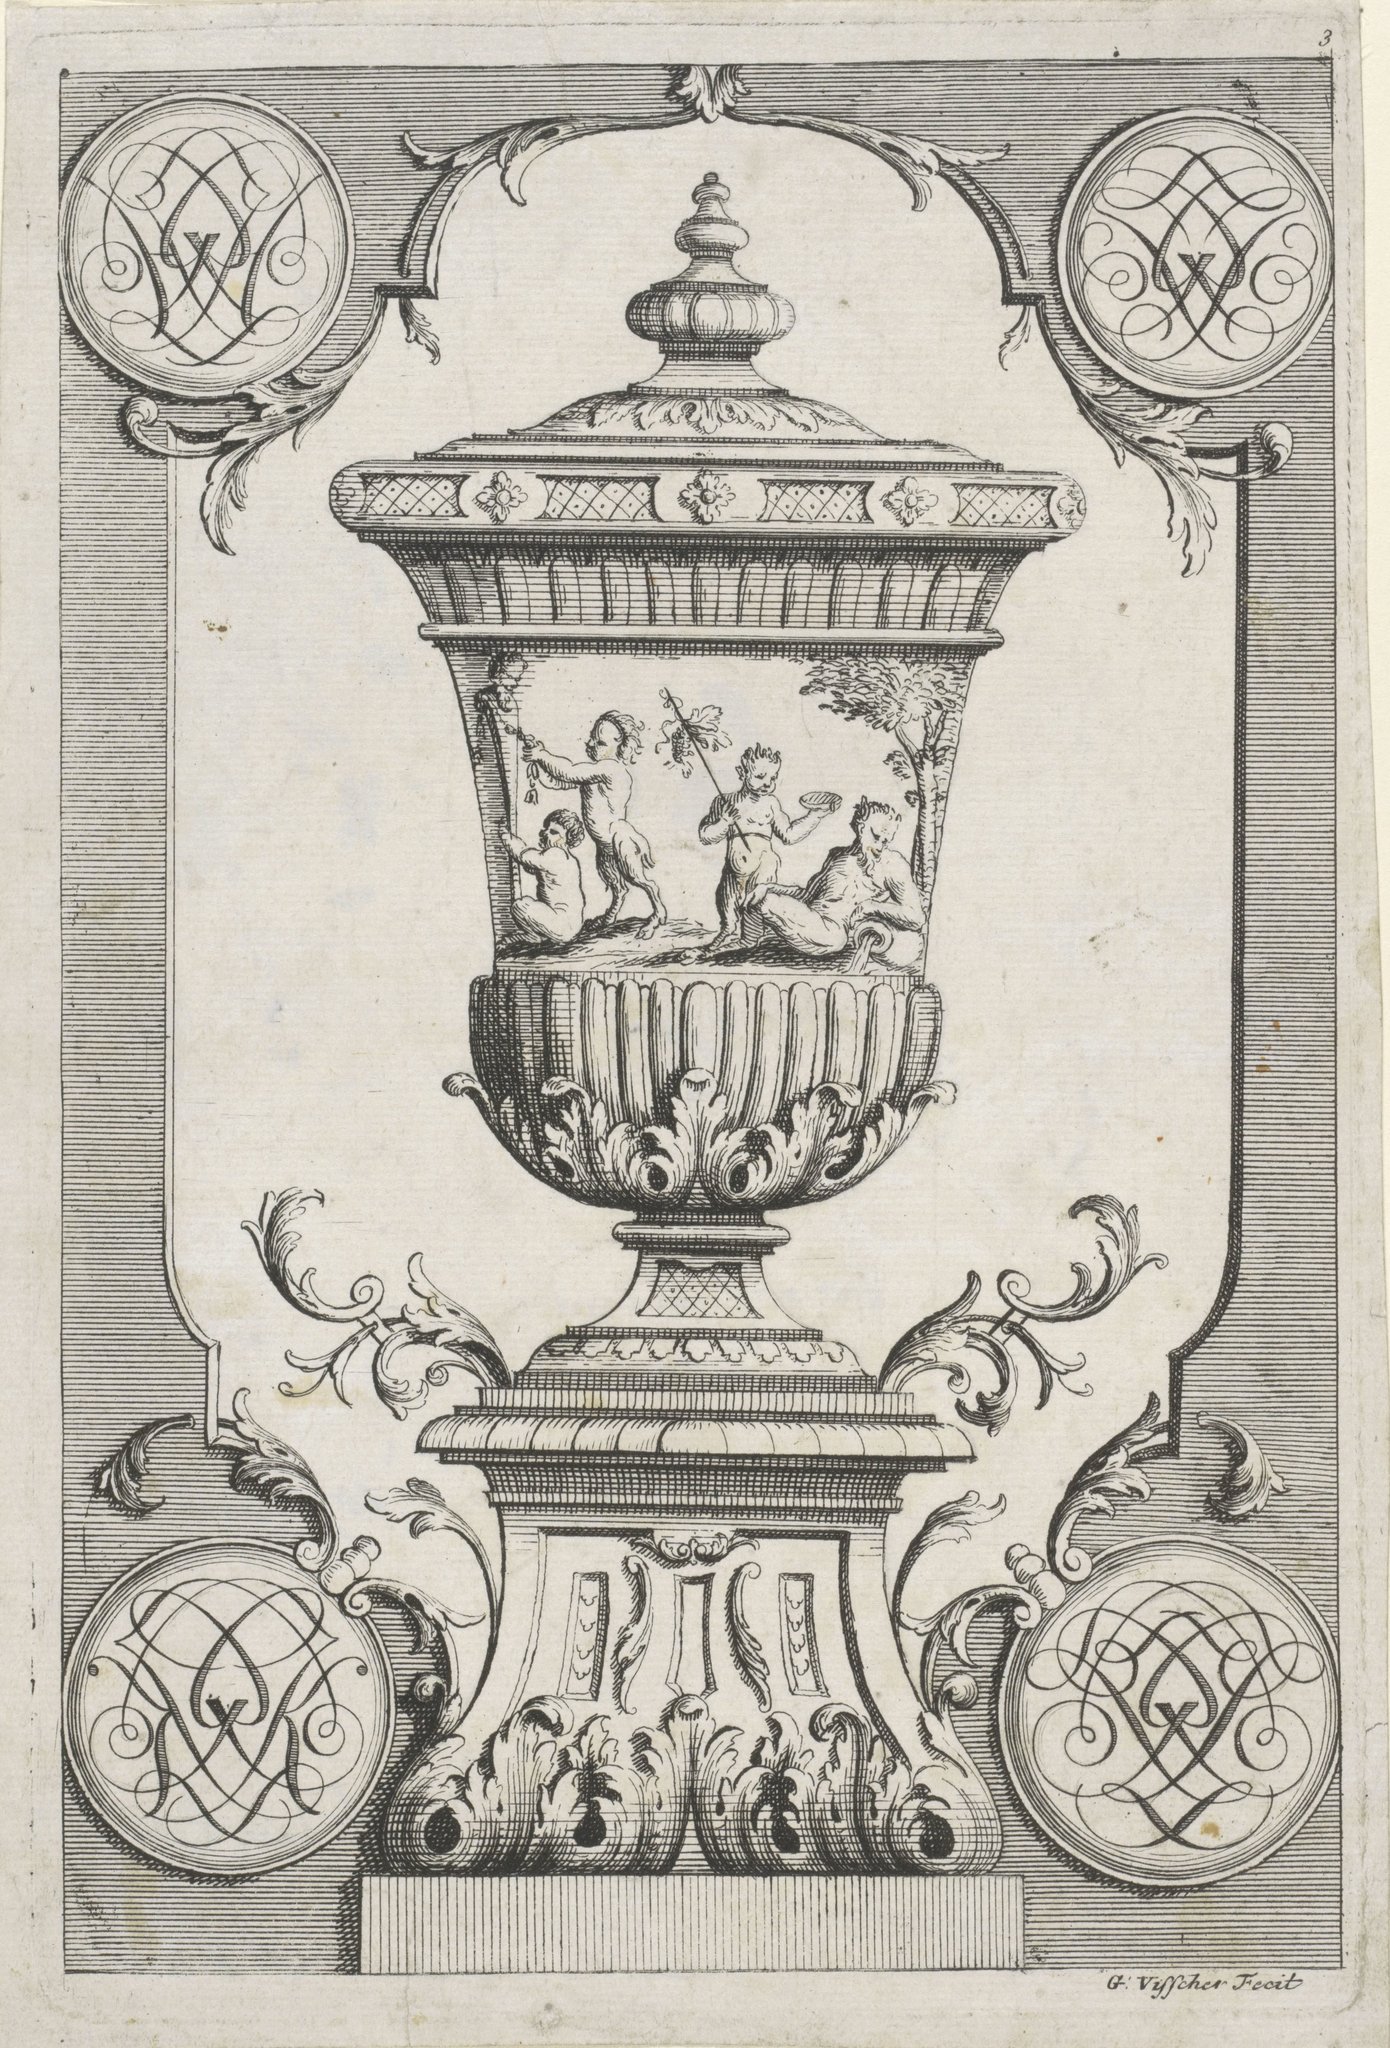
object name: ornament print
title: Paneel met tuinvaas met saters en in de hoeken monogrammen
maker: gerrit visscher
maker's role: print maker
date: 1690-1710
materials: paper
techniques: engraving, etching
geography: amsterdam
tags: ornaments ~ art, garden vase, letter combinations such as letterword, anagram, letter square, monogram, etc.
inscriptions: collector's mark: Lugt 2228